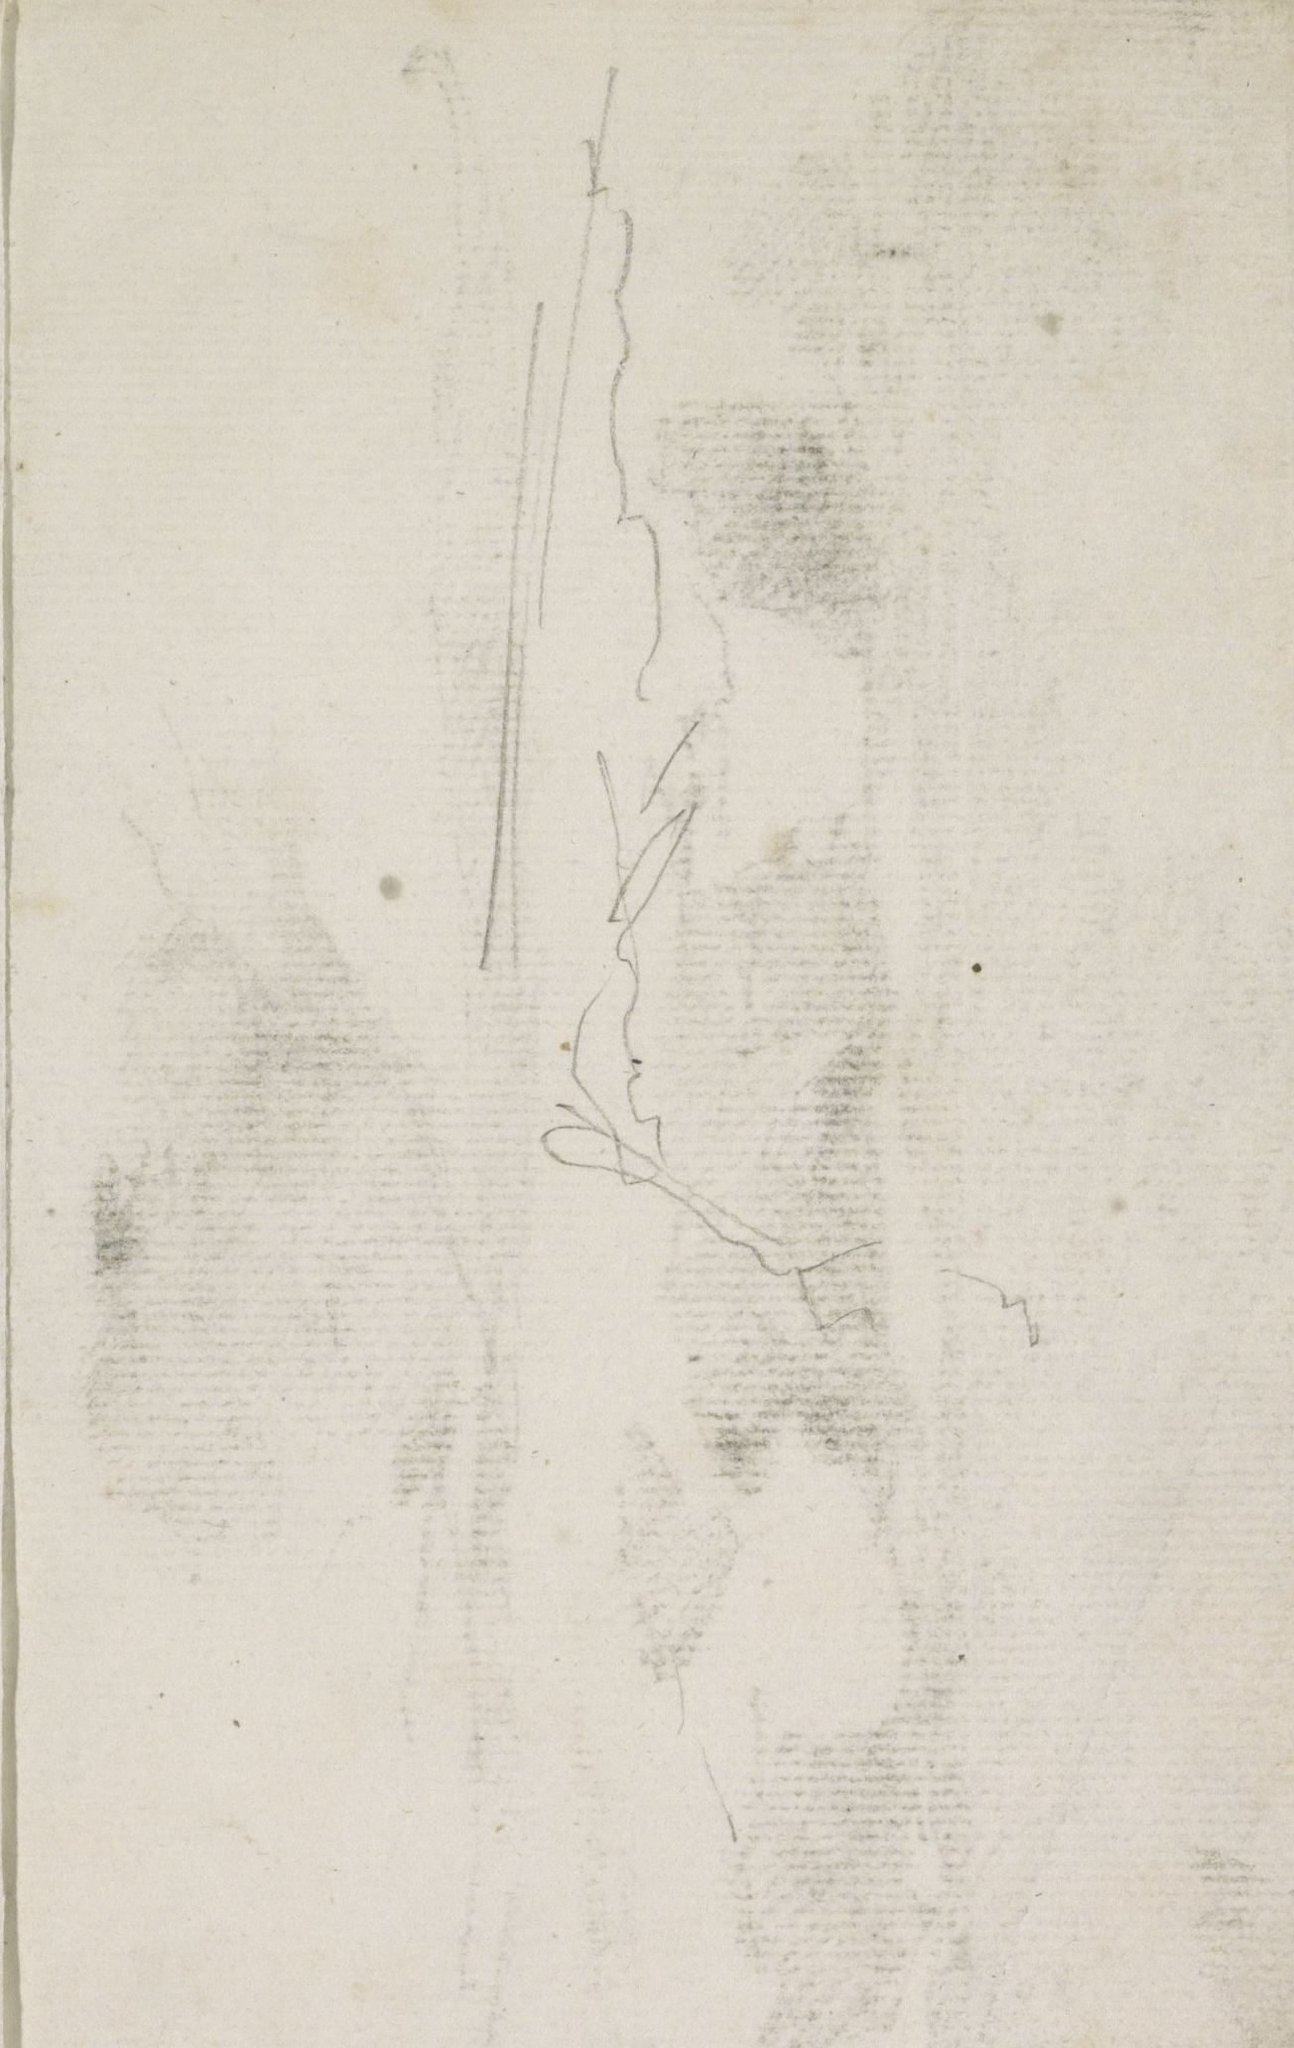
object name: sketchbook leaf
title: Studie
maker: george hendrik breitner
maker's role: draughtsman, painter, print maker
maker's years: 1857-1923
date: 1880-1882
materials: chalk, paper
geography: the hague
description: Pagina 32 uit een schetsboek met 29 bladen.